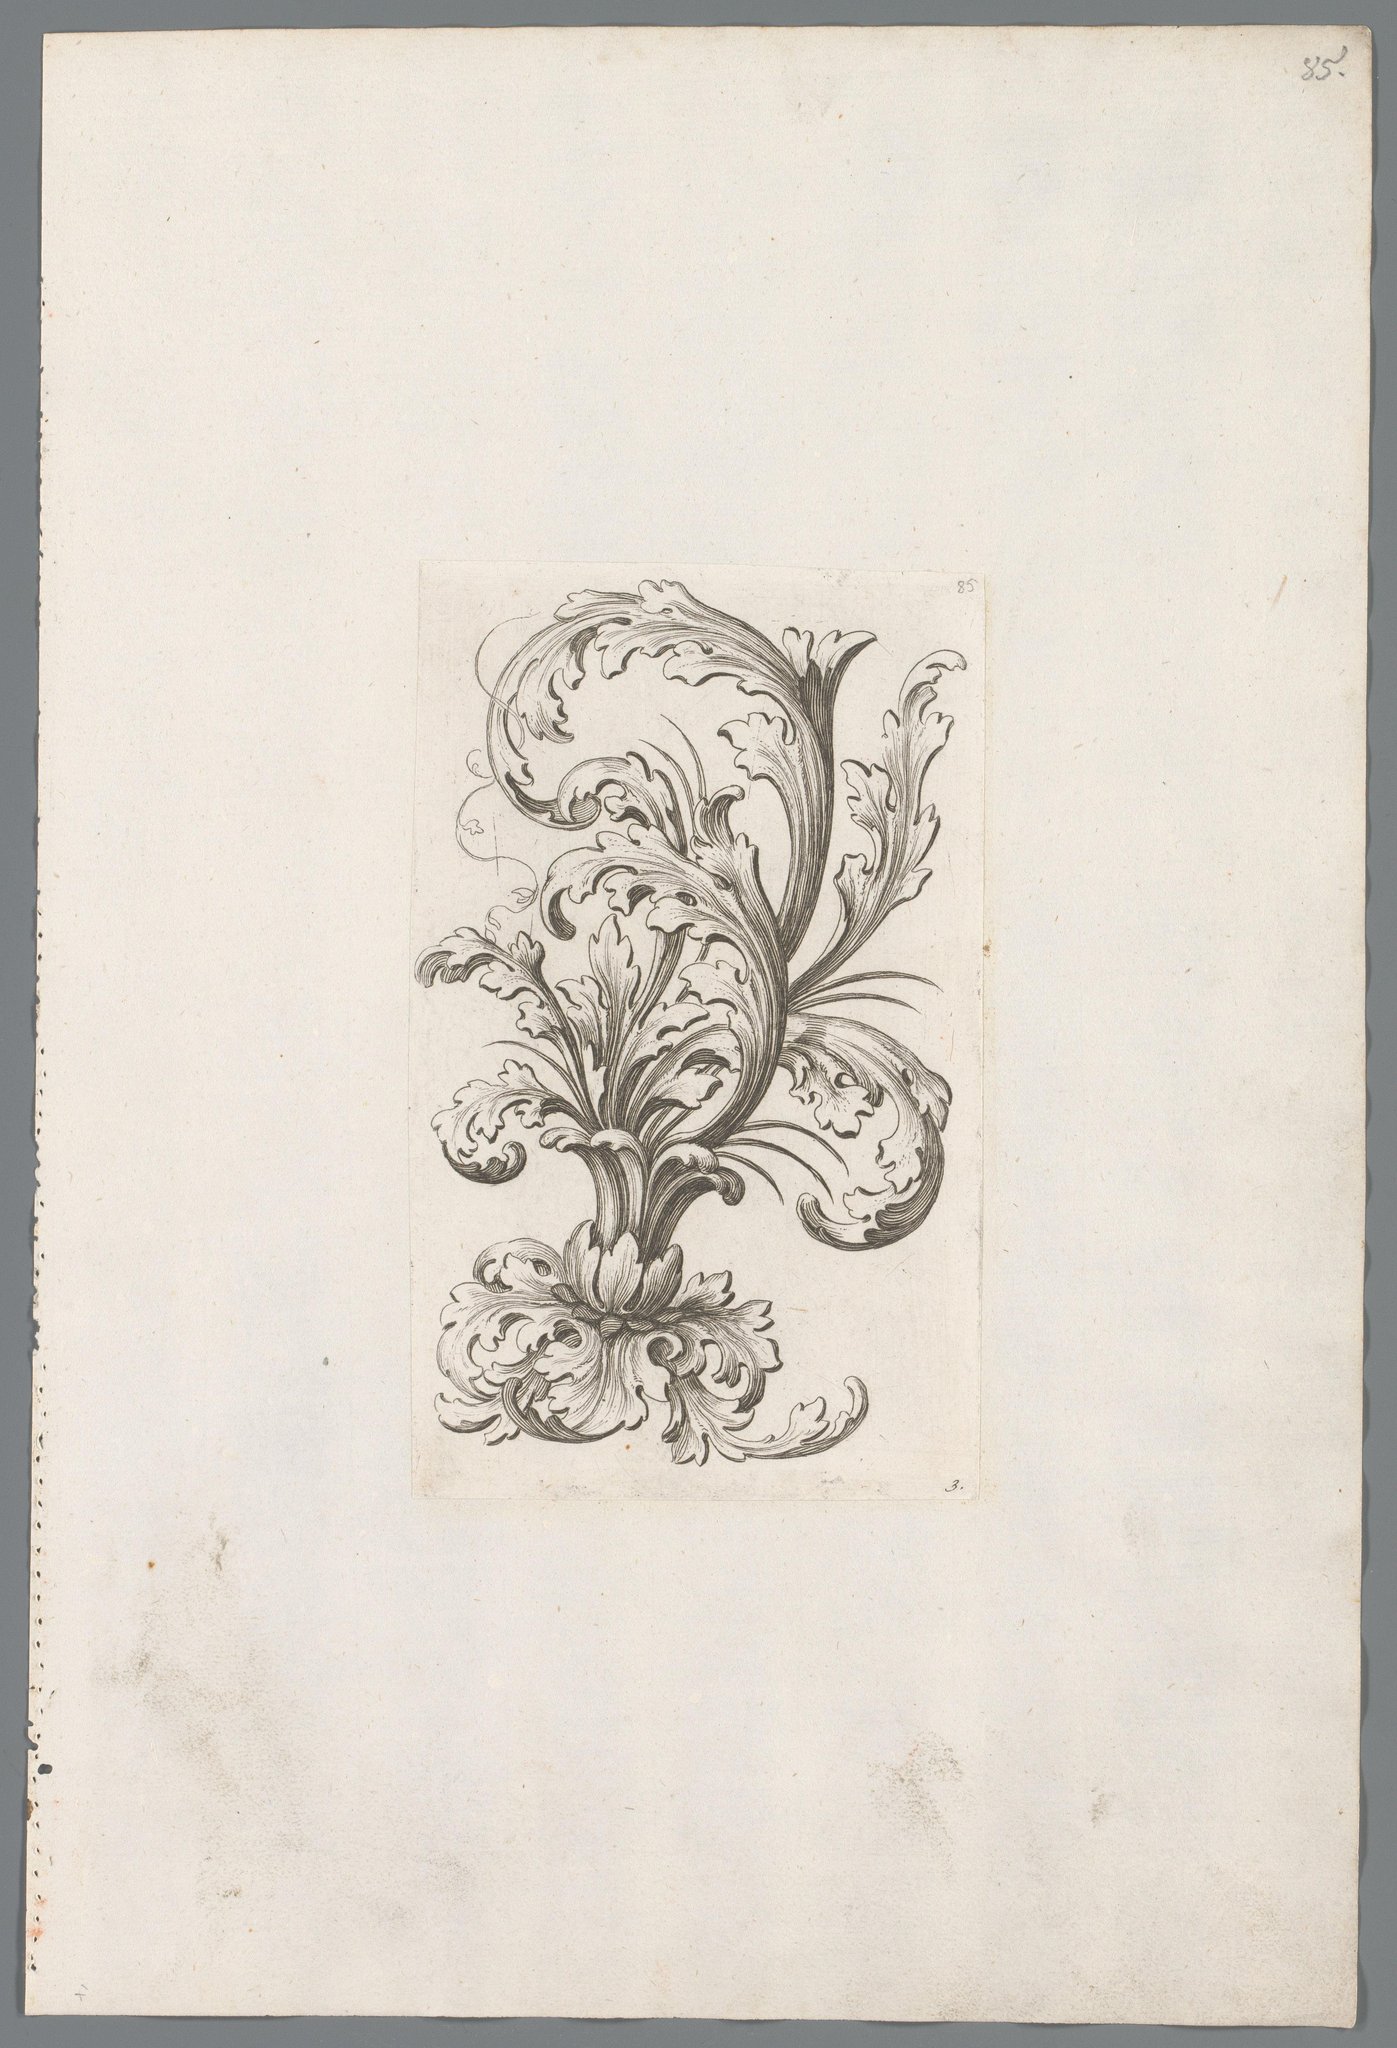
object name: print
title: Acanthusmotief met bloem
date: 1679-1700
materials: paper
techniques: etching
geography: augsburg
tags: acanthus ~ ornament, flowers ~ ornament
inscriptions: collector's mark: Lugt 2228, collector's mark: Lugt 2760